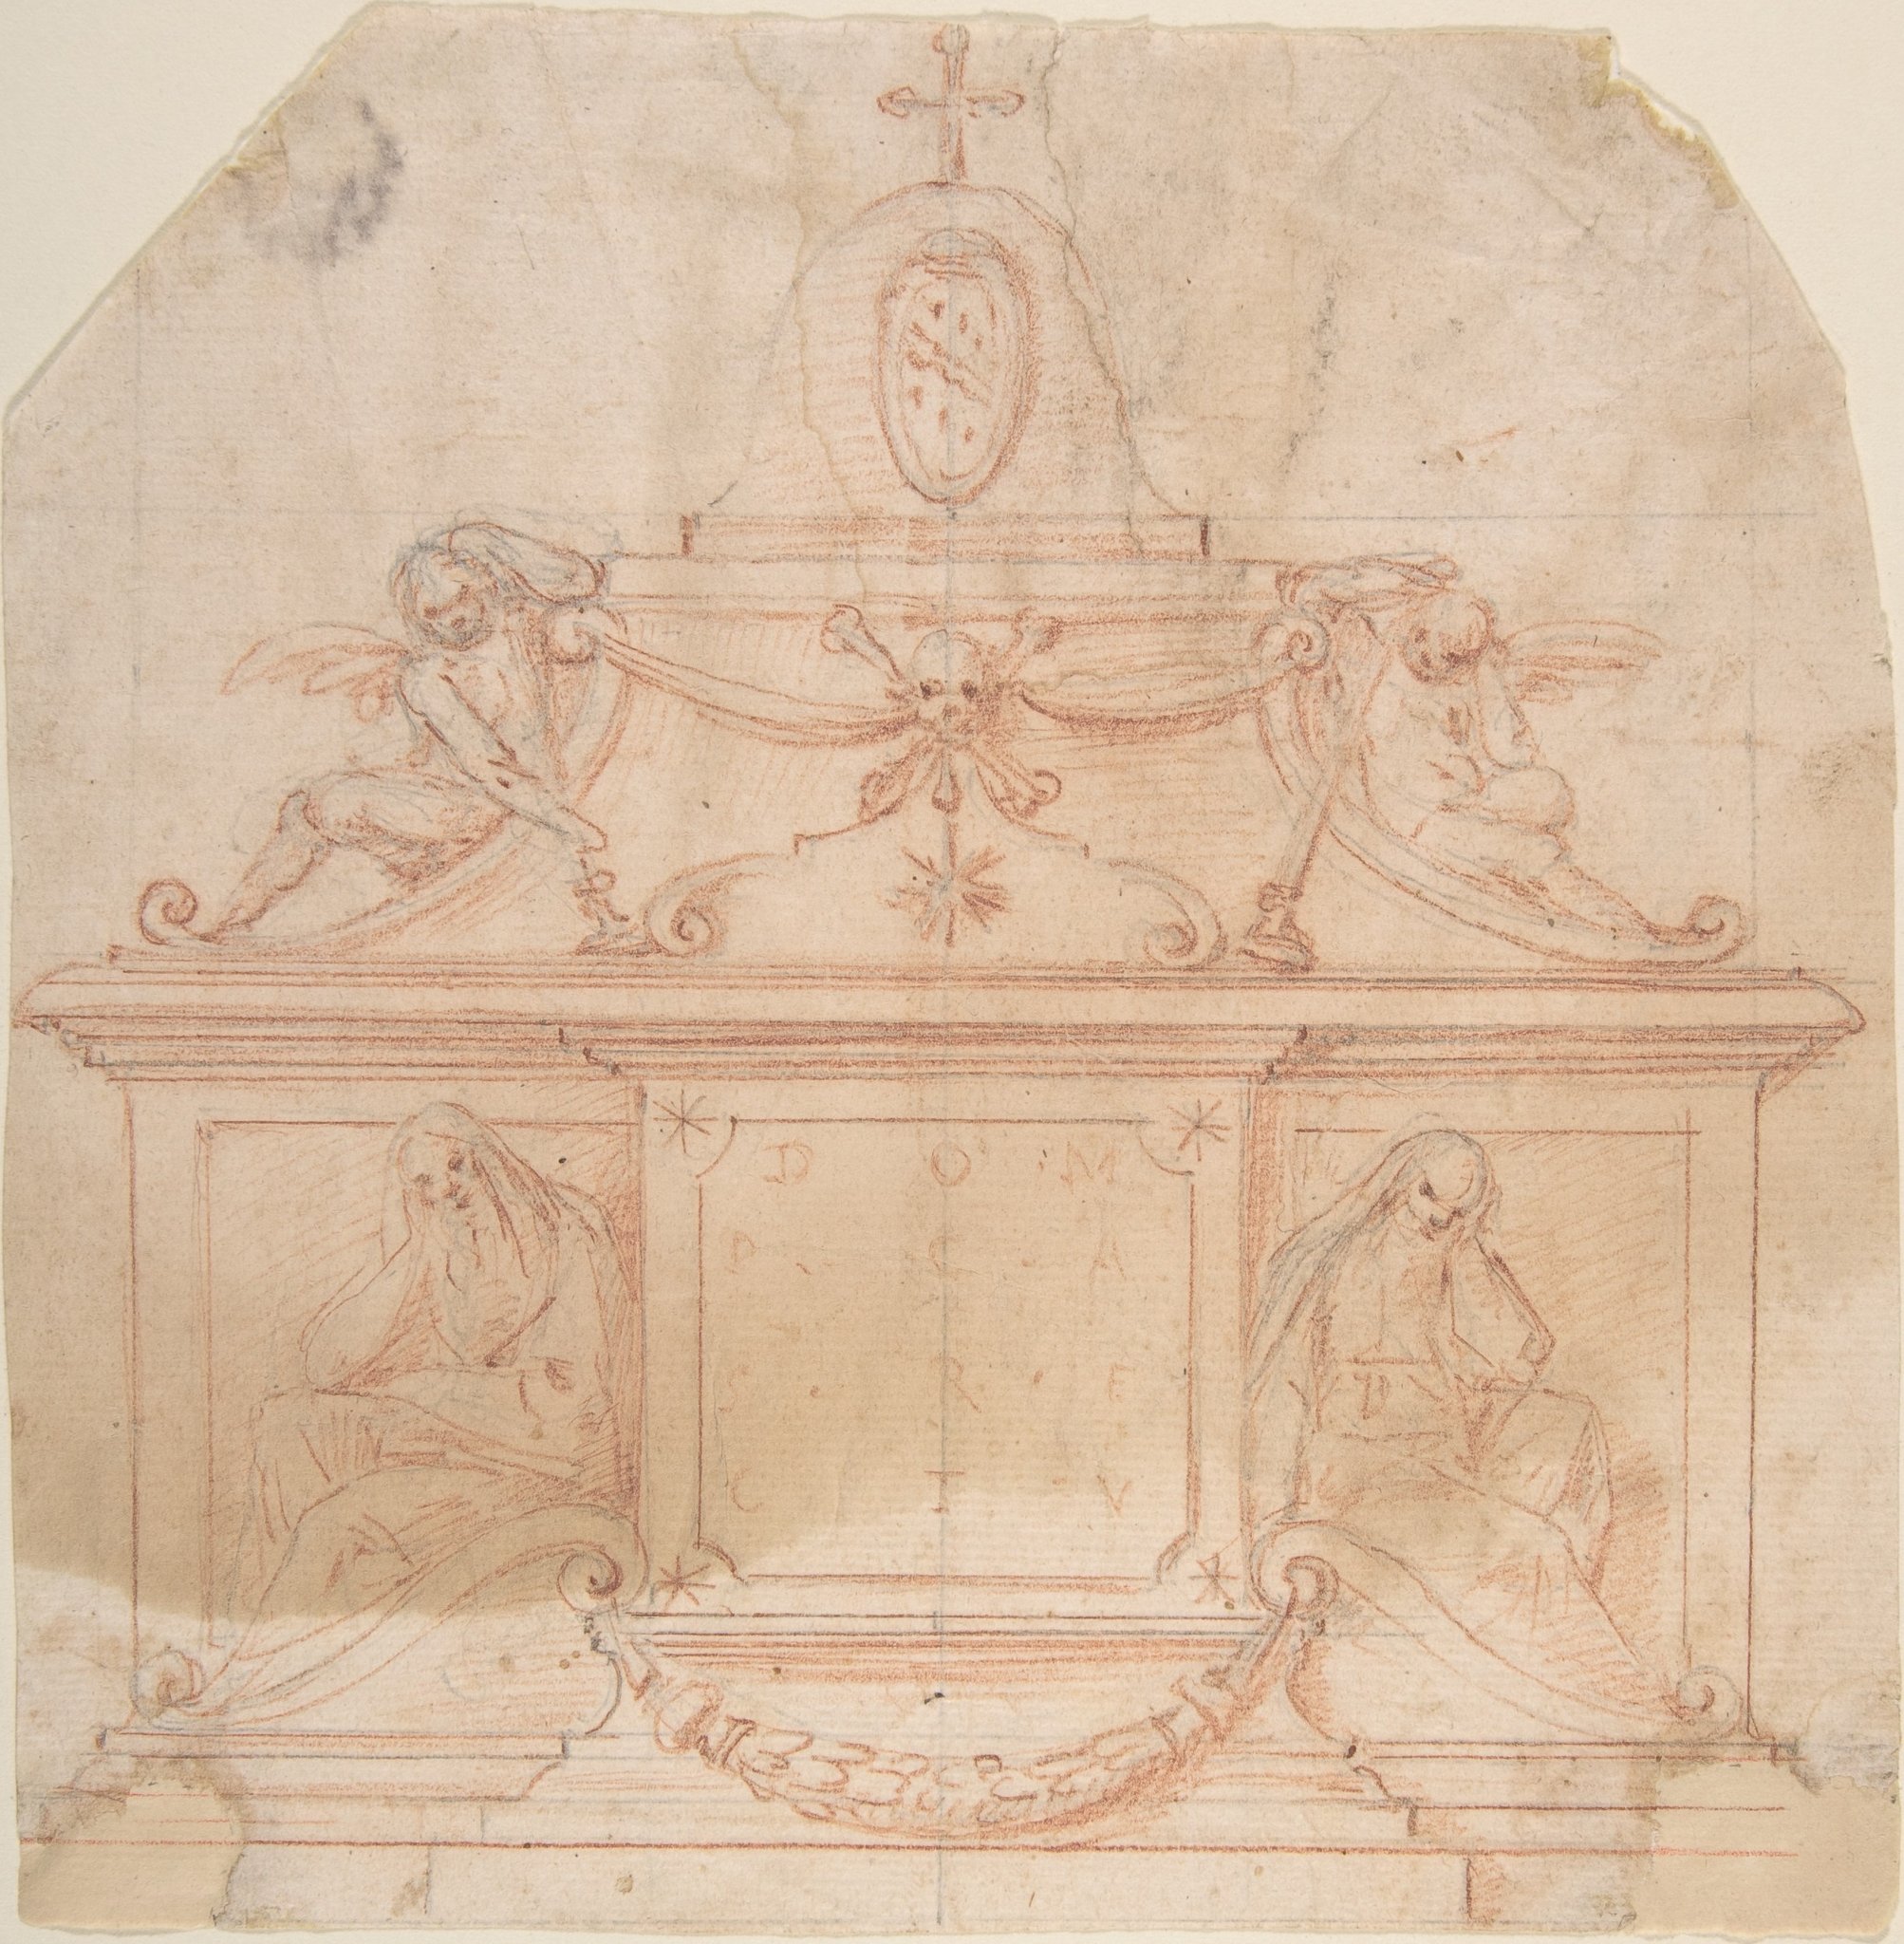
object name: drawing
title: Tomb Monument with Crucifix and Coat of Arms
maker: anonymous, italian, 17th century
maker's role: artist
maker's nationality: italian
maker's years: 1600-1700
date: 1601-1700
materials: chalk, graphite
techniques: drawing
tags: monuments,tombs